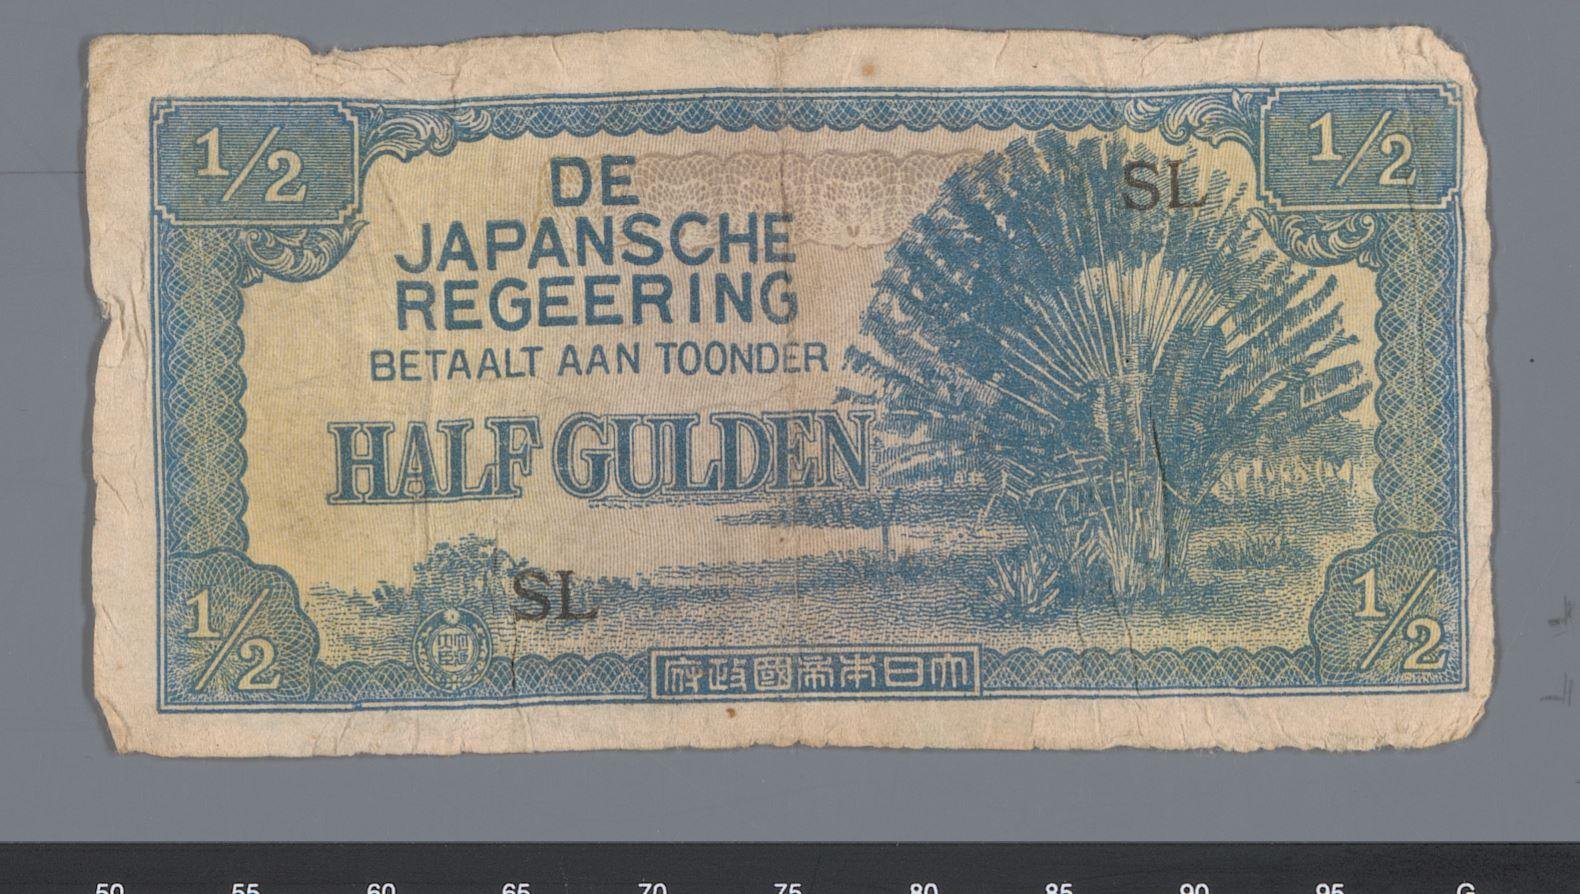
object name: bank note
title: Bankbiljet van een halve gulden uitgegeven door de Japanse Regering van Nederlands-Indië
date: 1942-1945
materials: paper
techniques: printing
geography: indonesia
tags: dutch east indies, the, japan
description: Biljet met blauwe opdruk 'De Japansche Regeering betaalt aan toonder HALF GULDEN', '1/2' en gestempeld 'SL'. Papier in het midden vergeeld.